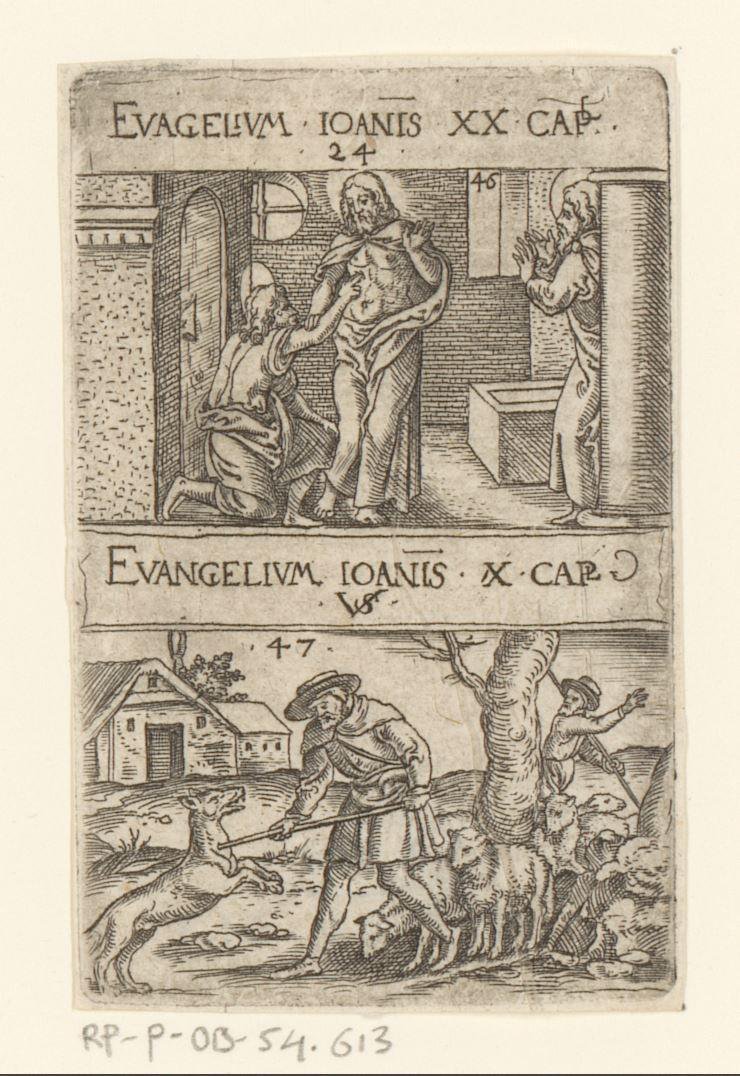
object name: print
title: Ongelovige Tomas en Christus als de goede herder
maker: virgilius solis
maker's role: draughtsman, print maker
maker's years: 1514-1562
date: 1524-1562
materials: paper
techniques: engraving, etching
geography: nuremberg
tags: thomas touching or stretching out his hands to touch the wound in christ's side, sometimes christ leading thomas' hand, the hireling is not the shepherd, he runs away when the wolf is coming ~ parable of the good shepherd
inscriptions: number: ‘88’, collector's mark: Lugt 2228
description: Deze prent maakt deel uit van een serie bestaande uit 27 genummerde prenten. De prenten tonen steeds twee evangelische scènes boven elkaar. Alle voorstellingen behalve de bovenste van de eerste prent zijn eveneens afzonderlijk genummerd.